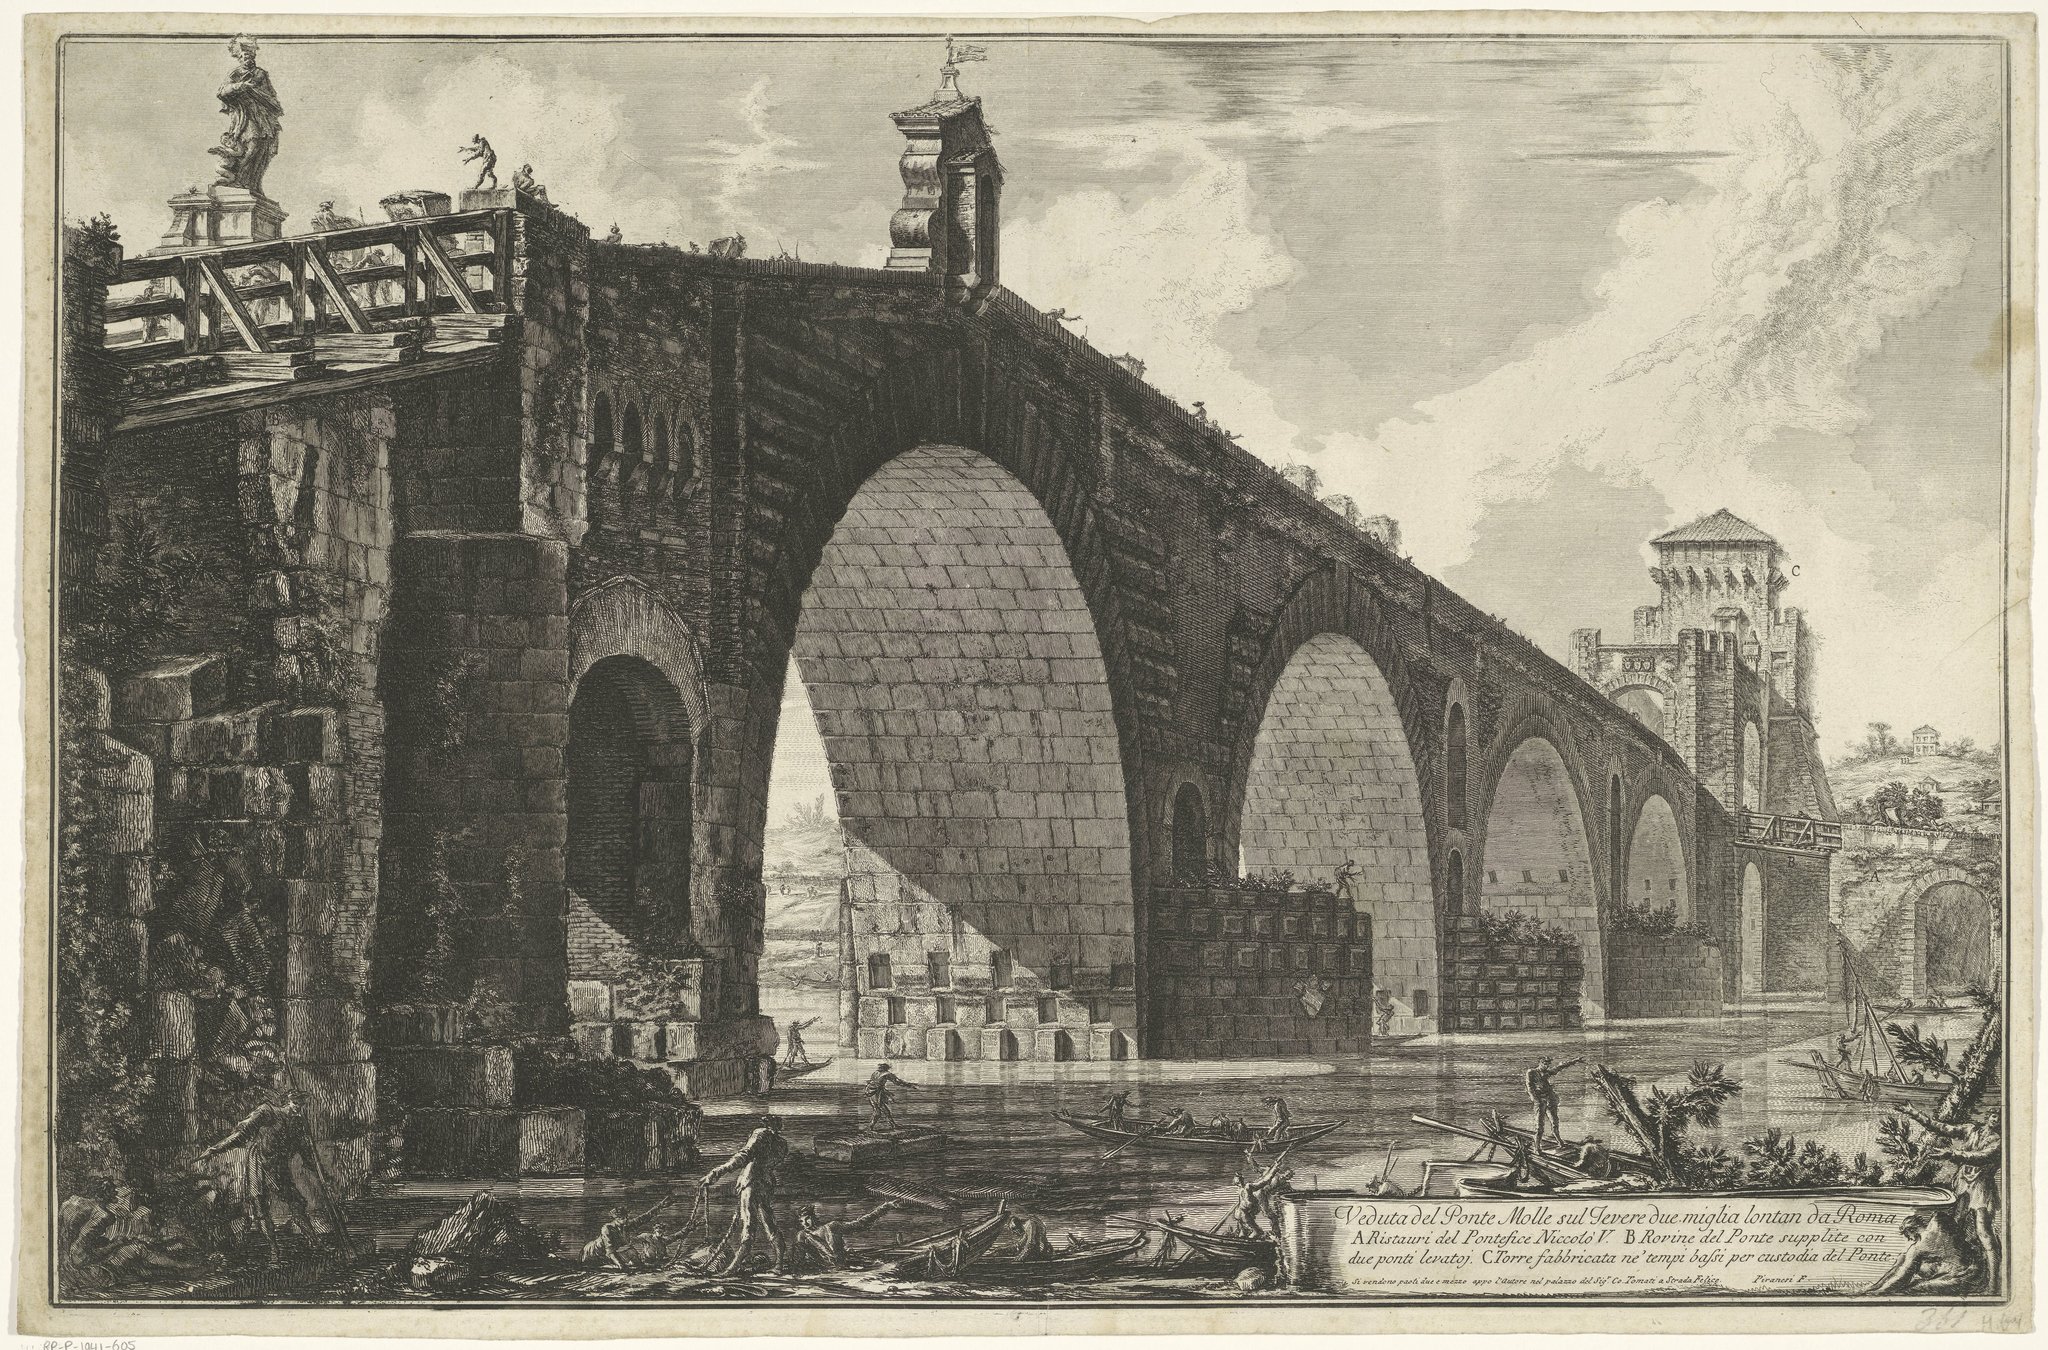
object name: print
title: Veduta del Ponte Molle sul Tevere due miglia lontan da Roma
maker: giovanni battista piranesi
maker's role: designer, draughtsman, print maker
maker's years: 1720-1778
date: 1748-1778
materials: paper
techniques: etching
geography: rome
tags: city-view, and landscape with man-made constructions, river, landscape with bridge, viaduct or aqueduct, bridge, rome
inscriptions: collector's mark: Lugt 2228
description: Deze prent maakt deel uit van de serie 'Vedute di Roma'. Piranesi werkte aan deze 135 platen tellende serie tussen 1748 en zijn dood in 1778. Francesco Piranesi voegde later nog twee prenten toe aan de reeks van zijn vader.